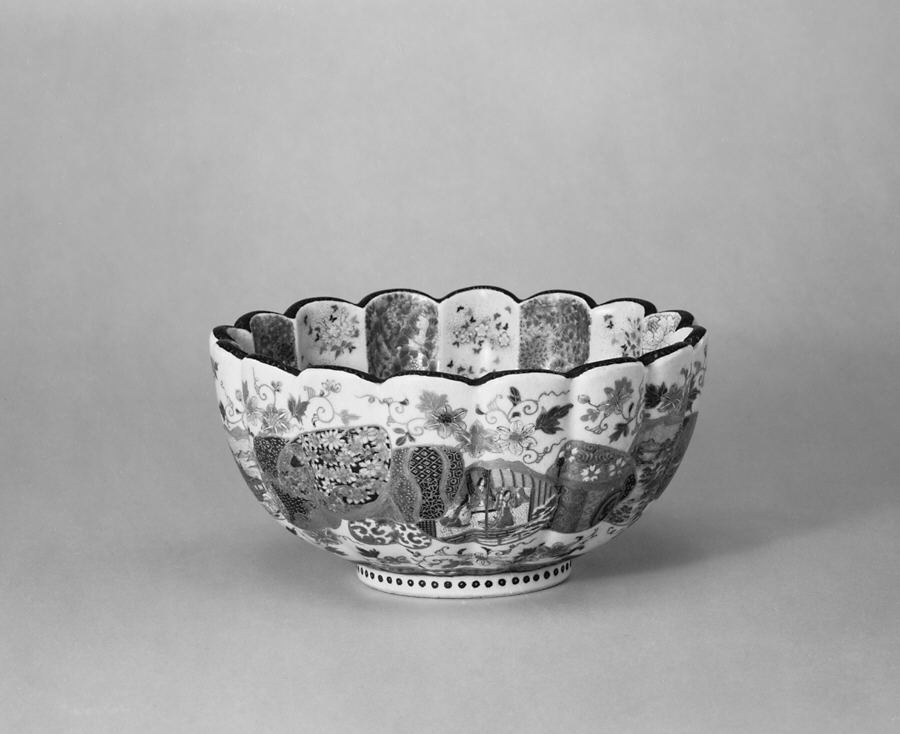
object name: bowl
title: Small Scalloped-shape Bowl with Design of Vertical Floral Bands and Chinese Children on Bottom of Interior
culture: japanese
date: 1801-1900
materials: earthenware, enamel, gold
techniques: overglaze, polychrome